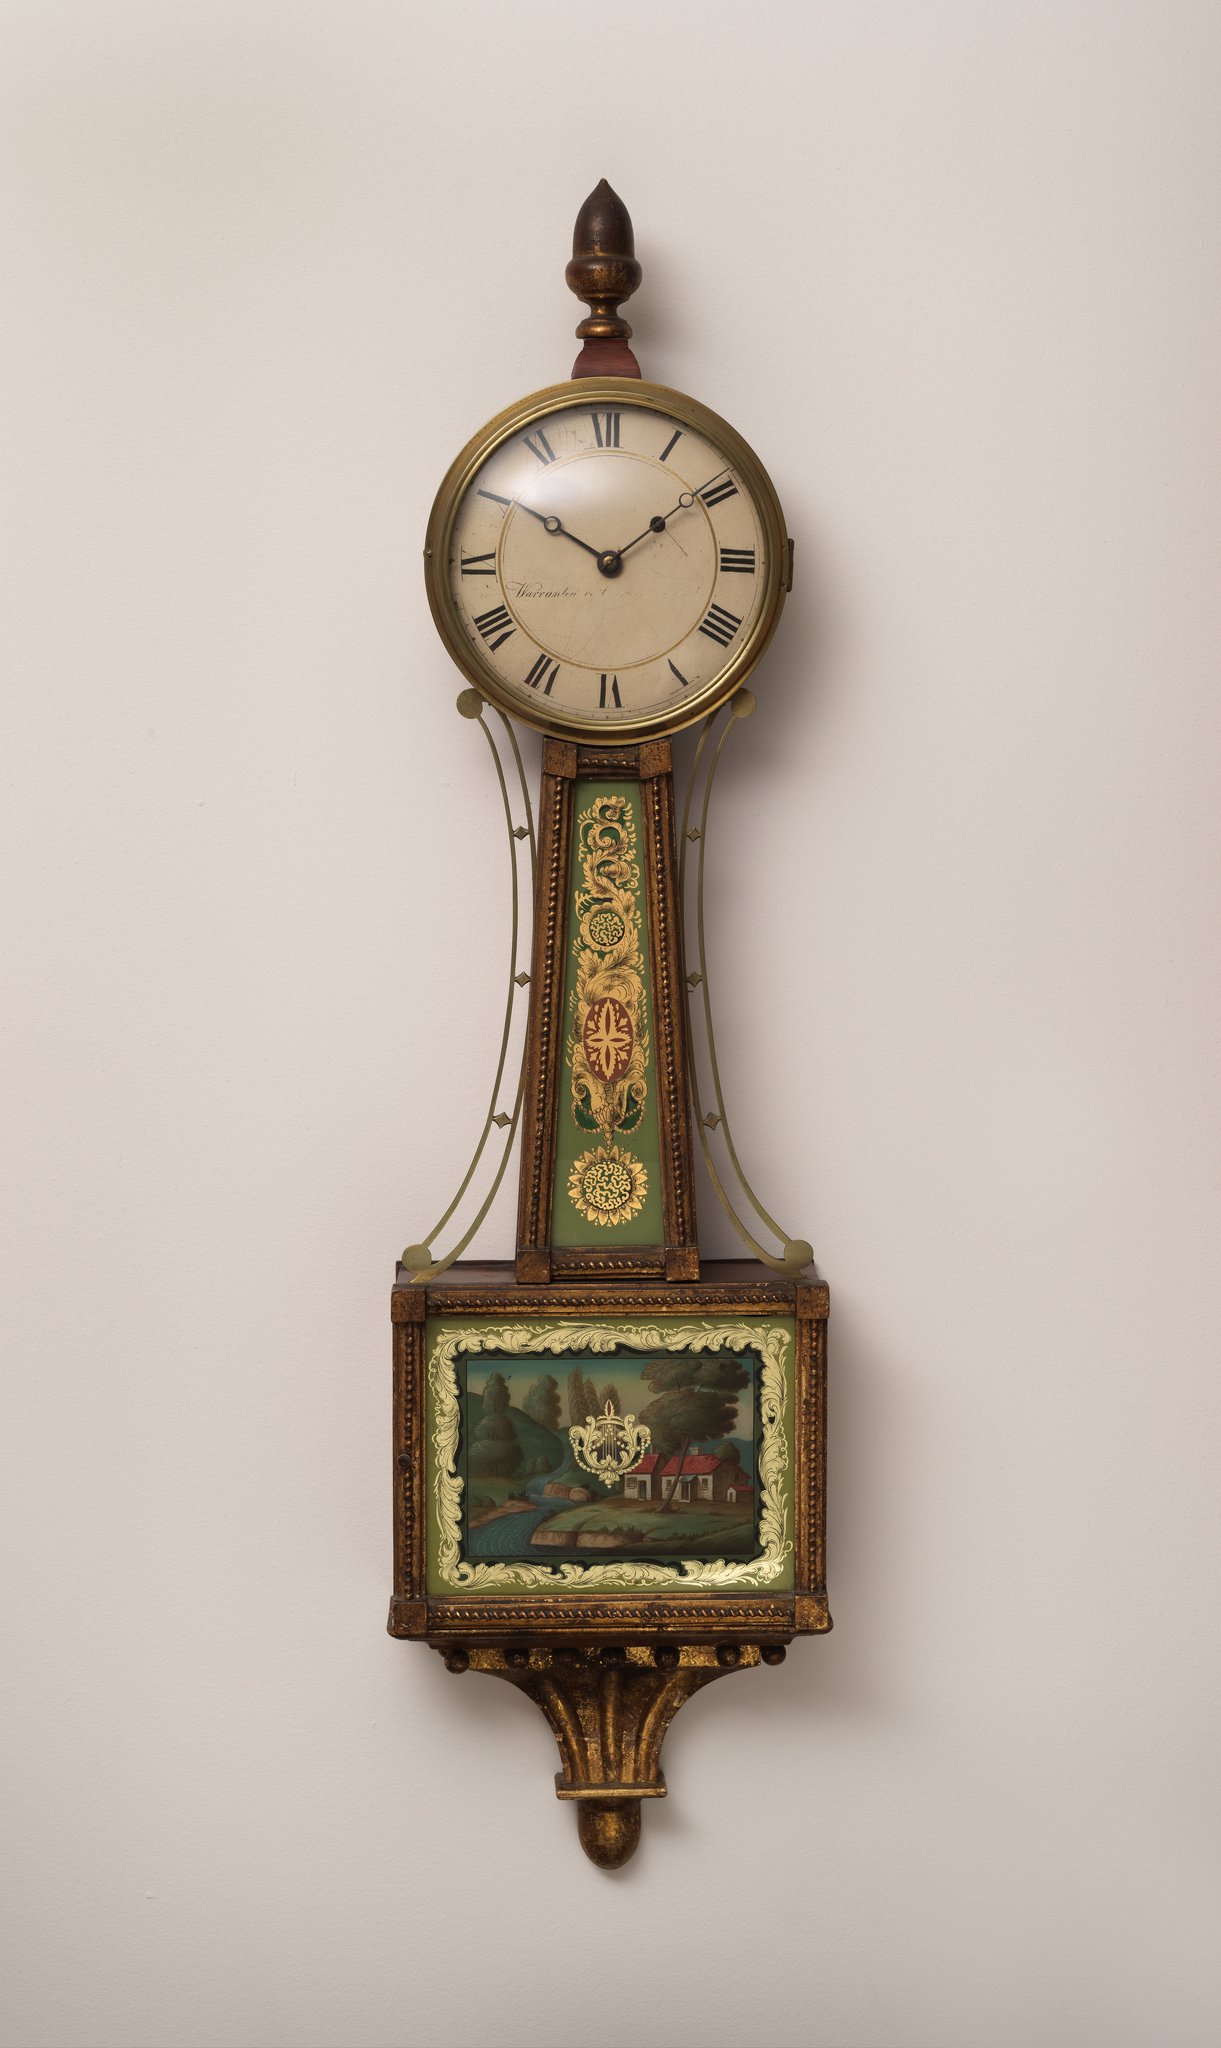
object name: banjo clock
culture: american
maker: curtis and dunning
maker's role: maker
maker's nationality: american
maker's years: 1816-1833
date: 1813-1816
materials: gesso, wood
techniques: gilding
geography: united states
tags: houses,landscapes